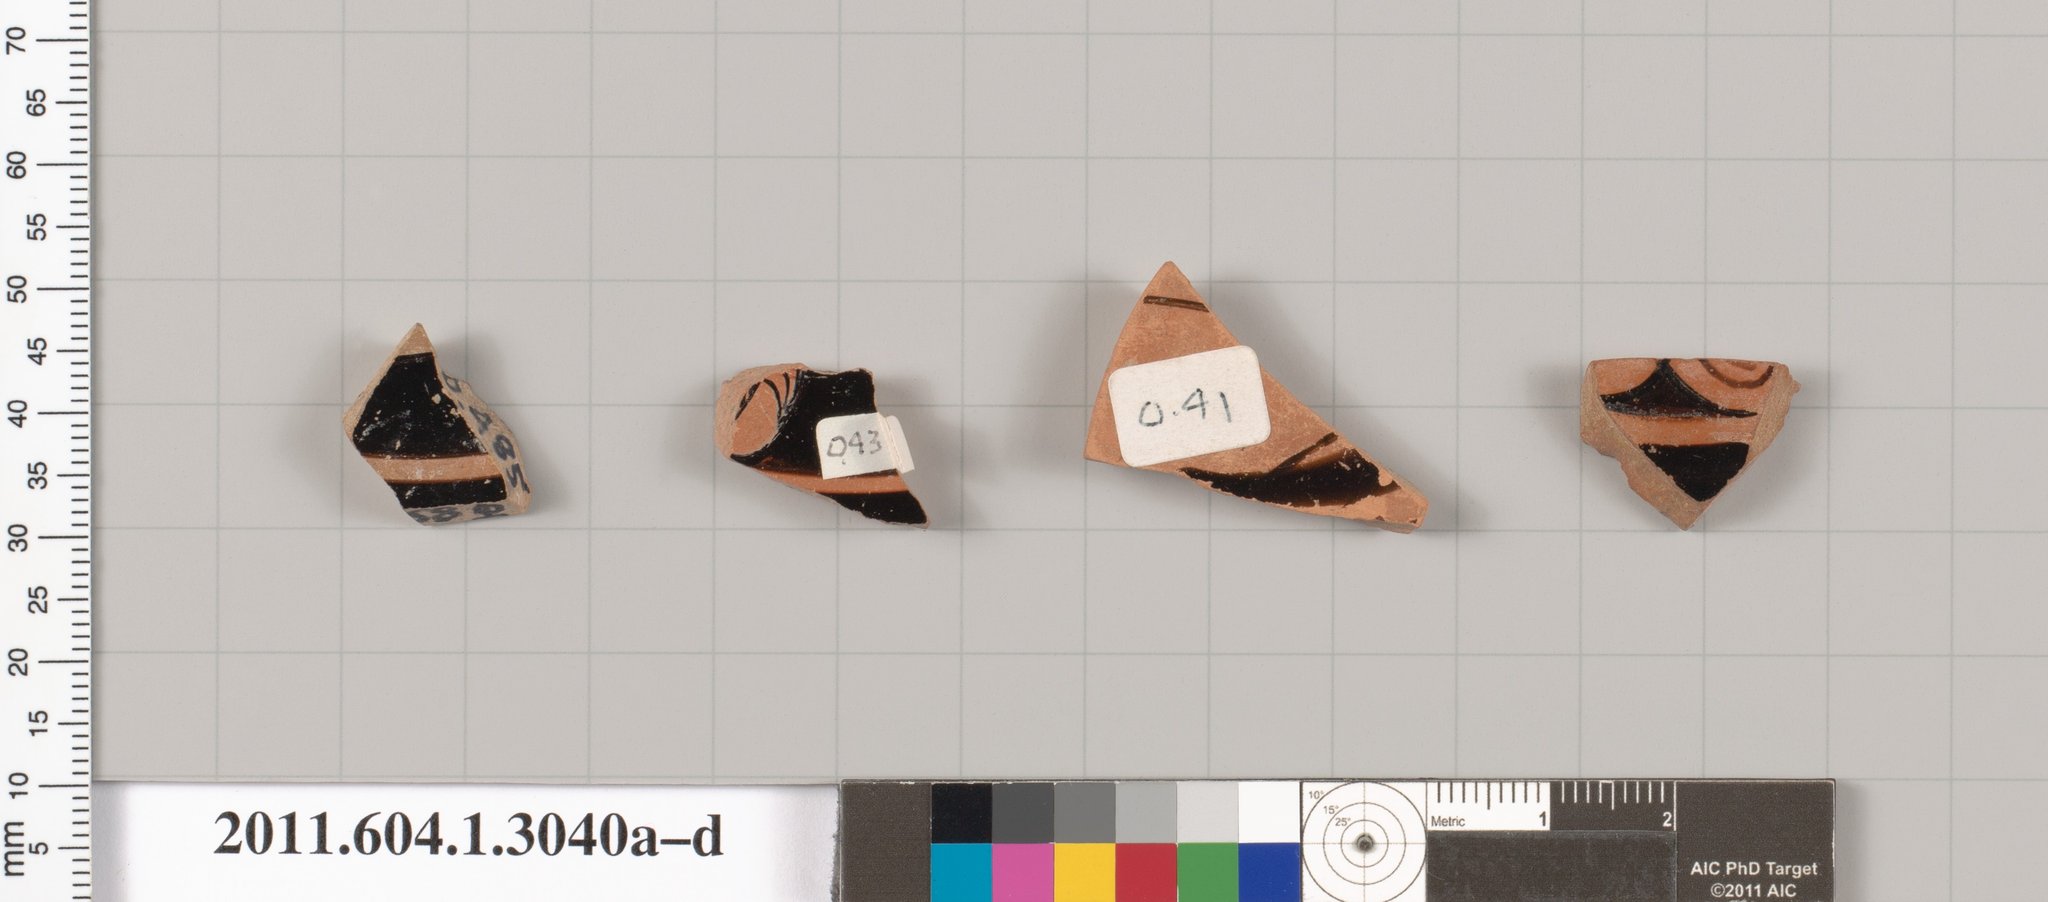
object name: kylix fragment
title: Terracotta fragments of kylikes (drinking cups)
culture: greek, attic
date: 520-480 BCE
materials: terracotta